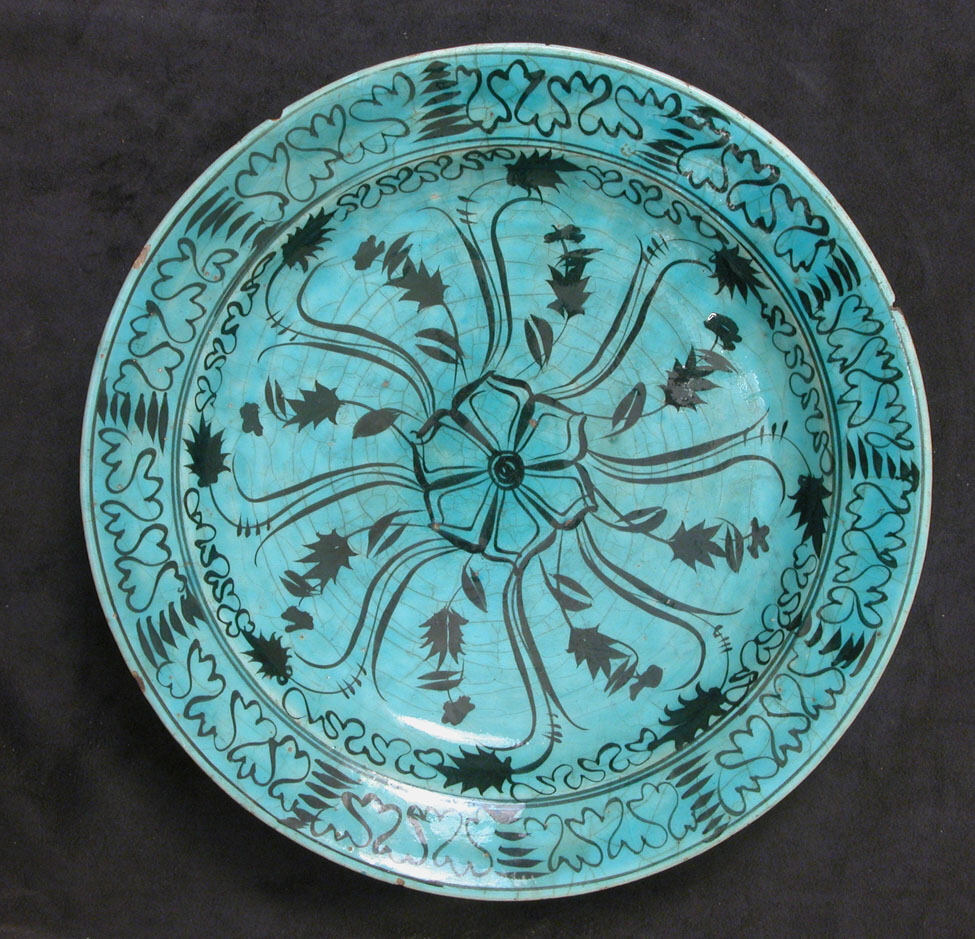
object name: dish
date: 1501-1700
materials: glaze, stonepaste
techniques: painting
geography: iran